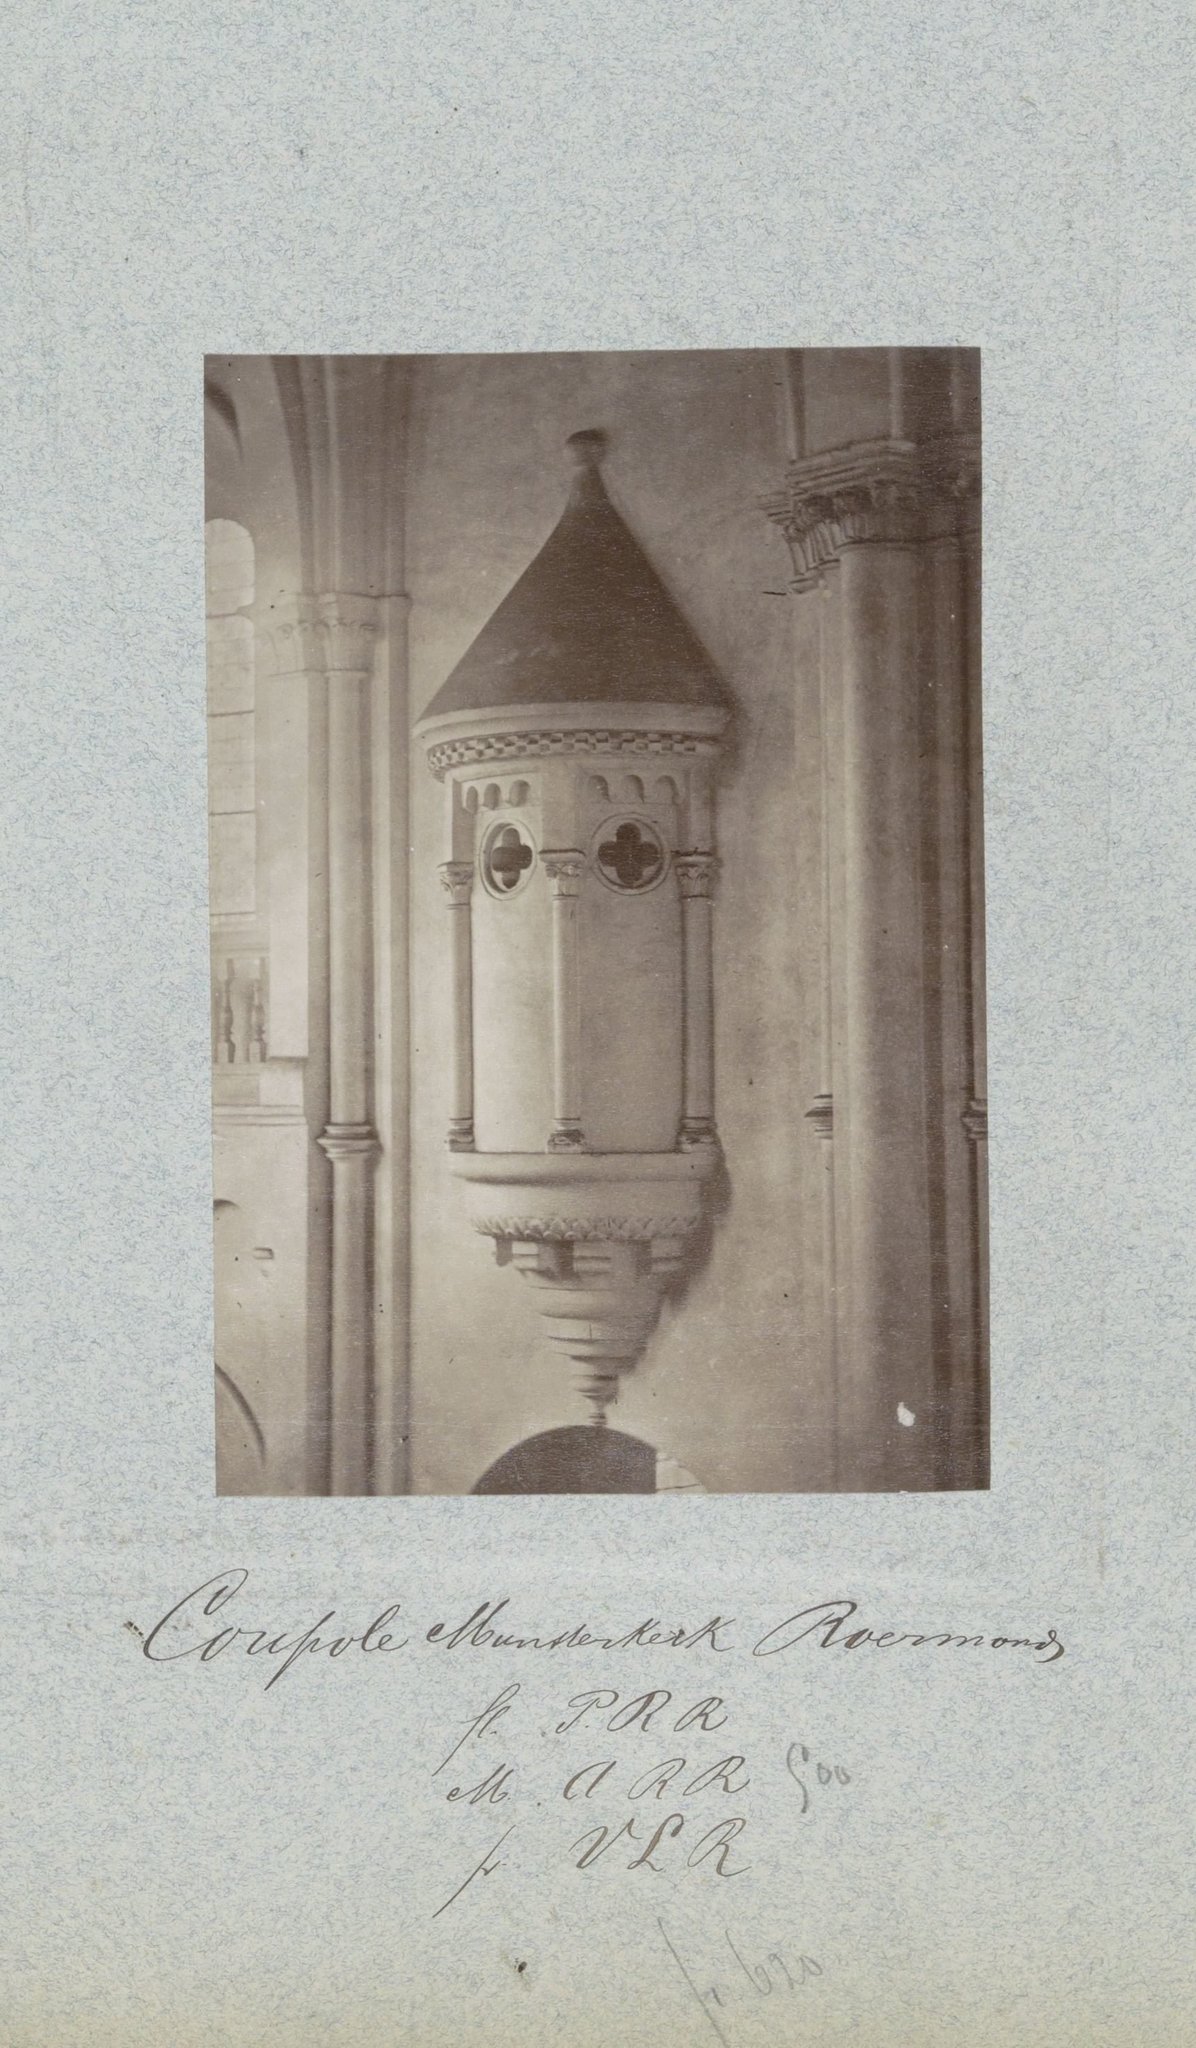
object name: photograph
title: Munsterkerk in Roermond te Limburg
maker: Anonymous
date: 1875-1900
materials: paper, photographic support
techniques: albumen print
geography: roermond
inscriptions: annotation, annotation: ‘Coupole Munsterkerk Roermond’